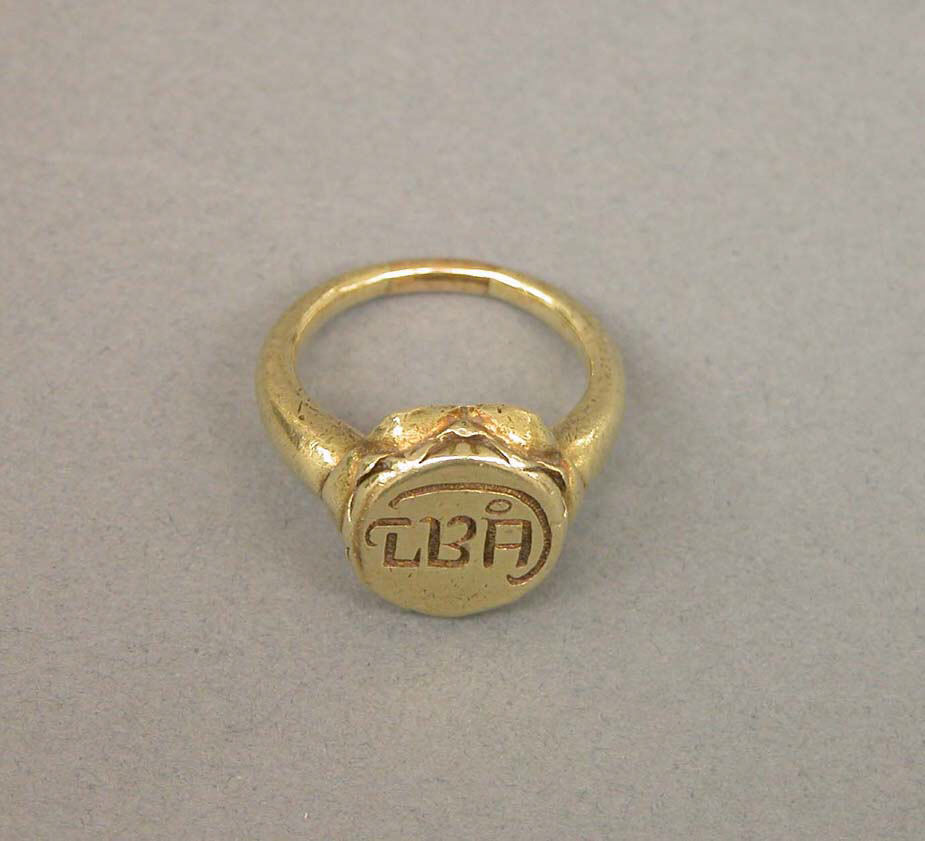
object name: ring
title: Ring with Circular Bezel with "Java Kuno" Inscription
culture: indonesian, javanese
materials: gold